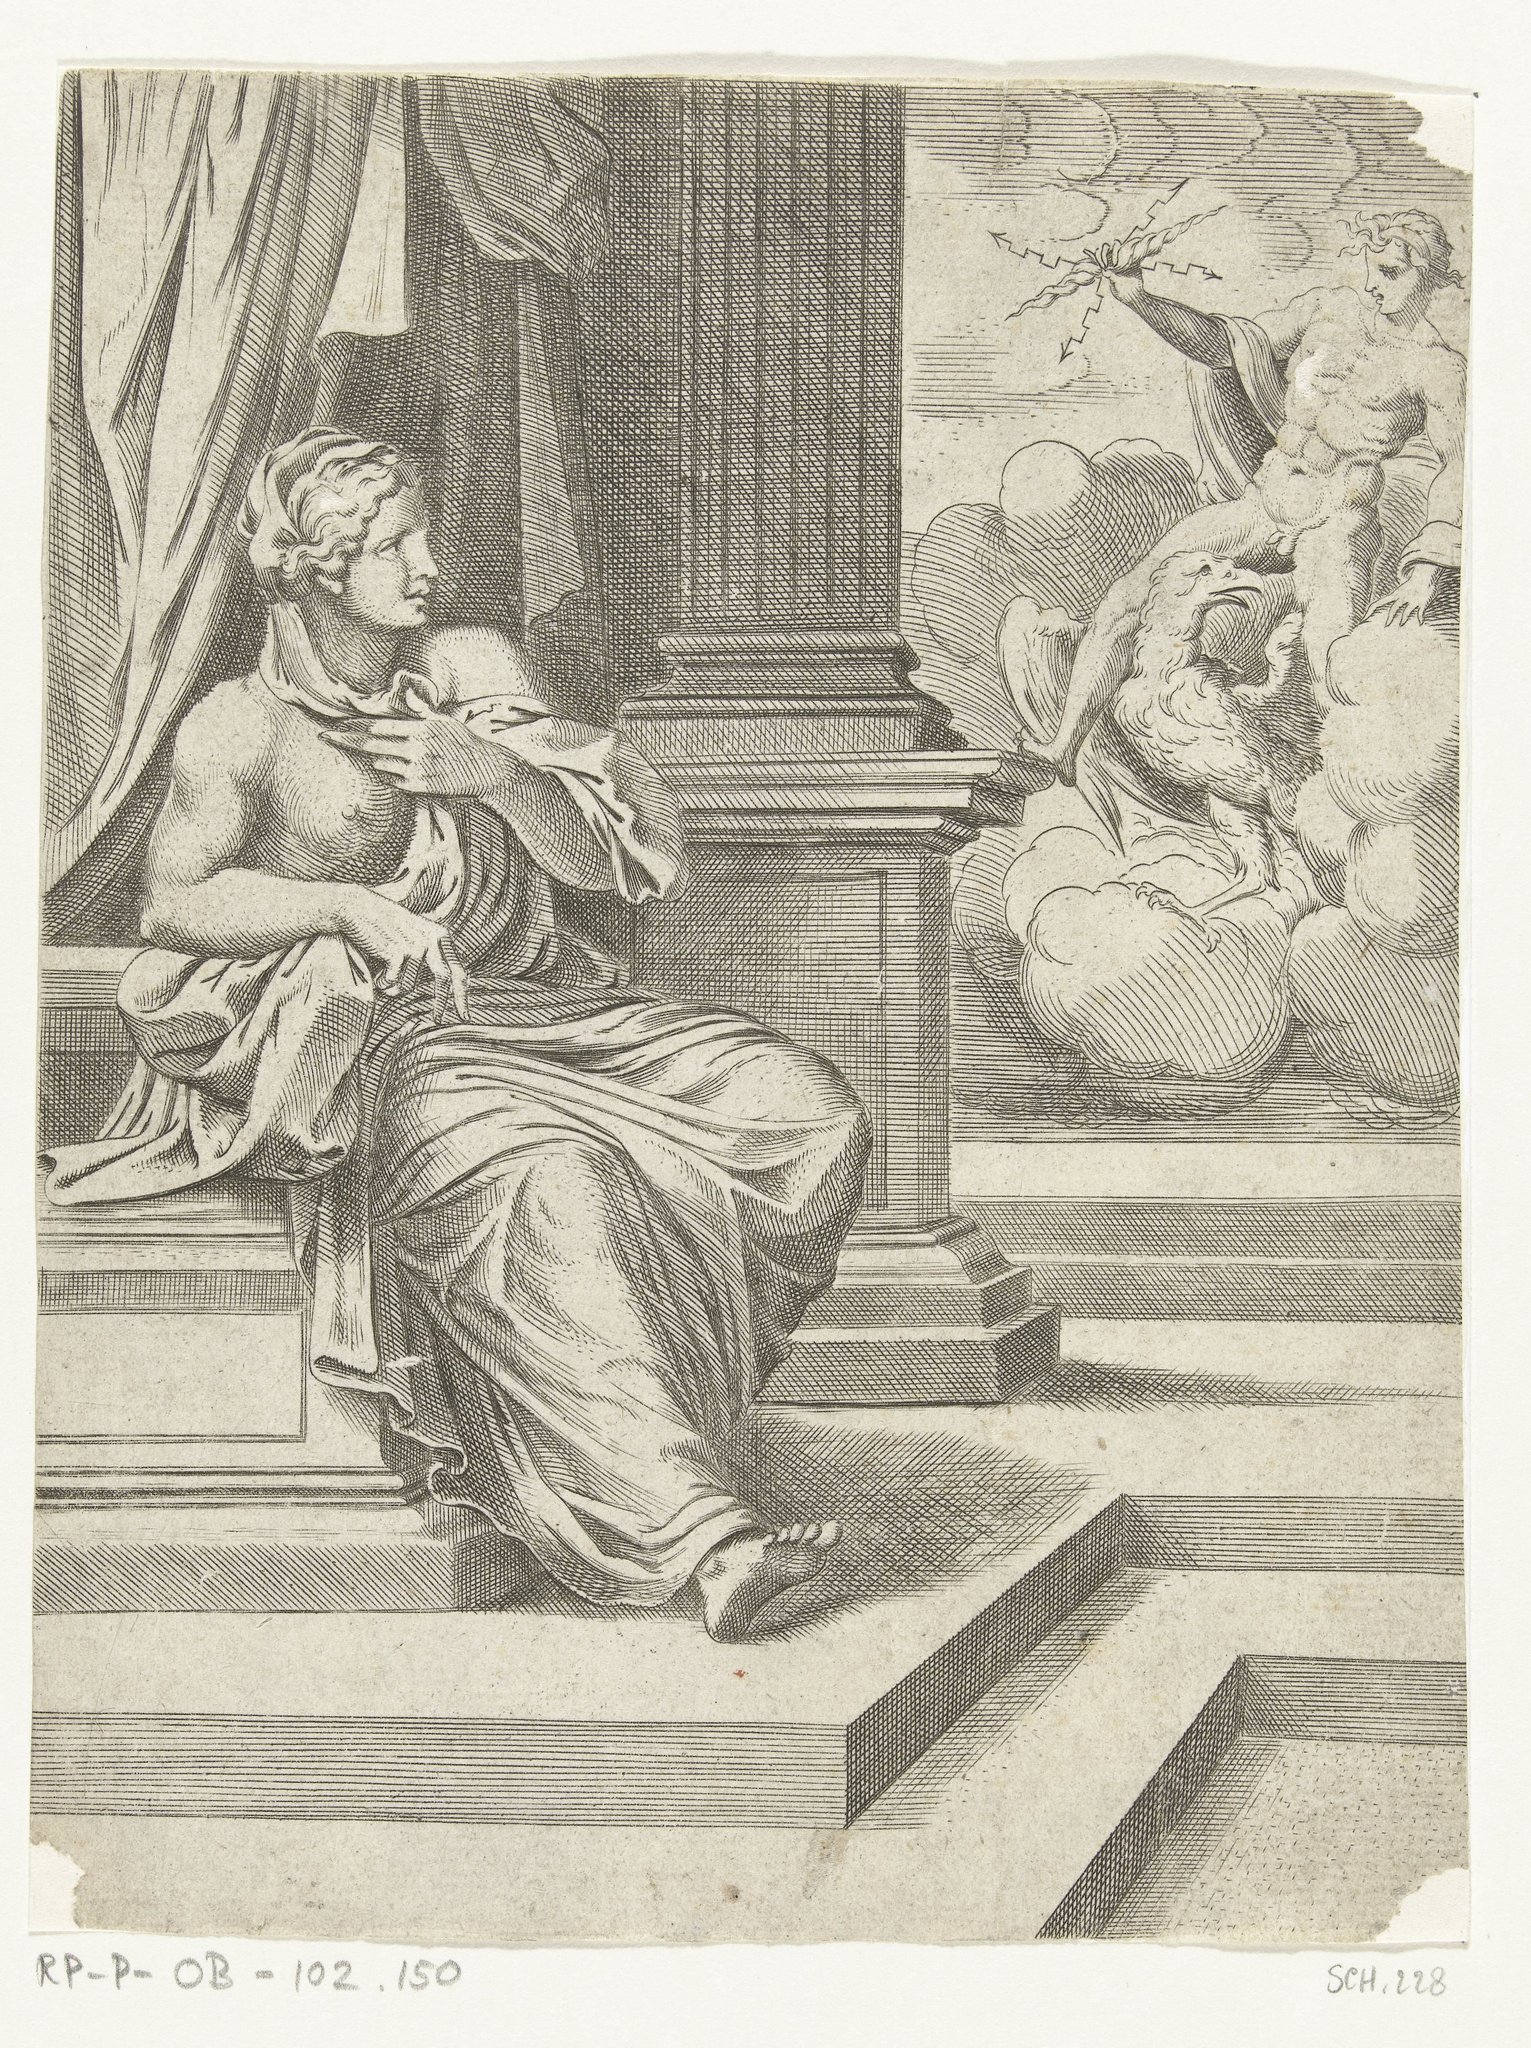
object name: print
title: Jupiter en Semele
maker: cornelis bos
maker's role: print maker, printer, publisher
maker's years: 1510-1566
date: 1537-1555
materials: paper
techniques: engraving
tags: jupiter wooing semele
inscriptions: collector's mark: Lugt 2228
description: Jupiter verschijnt voor Semele. Hij staat tussen wolken, met de bliksemschichten in zijn hand. Zijn adelaar staat tussen zijn benen. Semele zit op een stenen bank op hem te wachten. Prent uit een serie van 10 prenten die het liefdesleven van Jupiter illustreren.